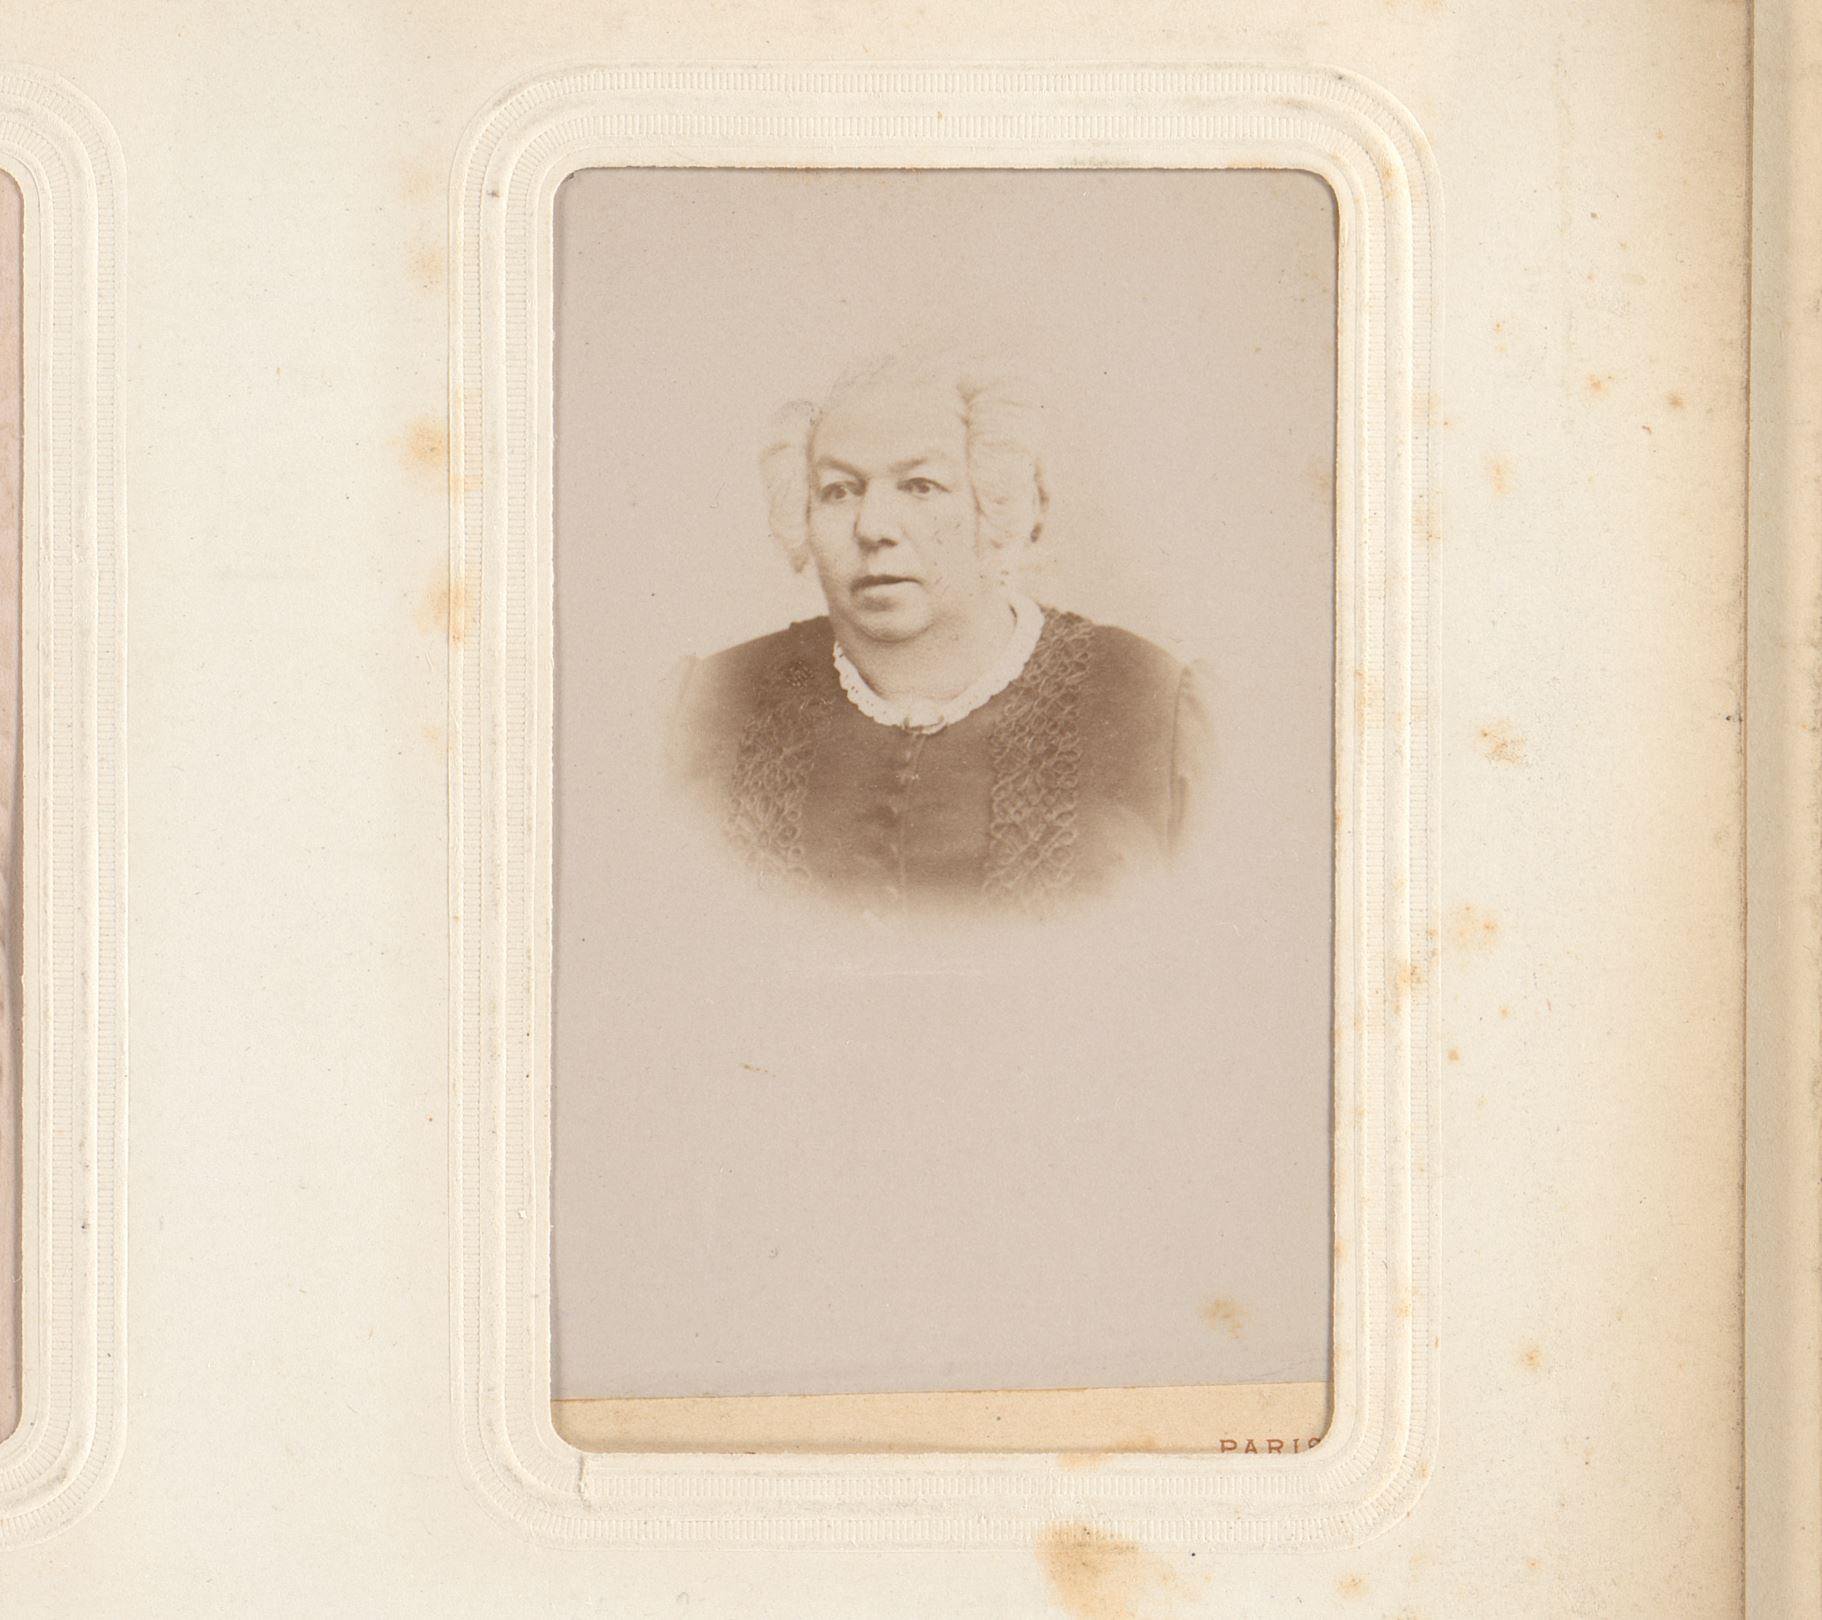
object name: album leaf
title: Portret van een vrouw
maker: michel berthaud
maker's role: publisher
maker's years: 1845-1912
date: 1891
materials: cardboard, paper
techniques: albumen print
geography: paris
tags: adult man, historical persons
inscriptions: inscription: ‘MEDAILLE D'OR/ 1889/ BERTHAUD/ 9, Rue Cadet, 9/ PARIS/ Tous le clichés sont conservés/ NO.... 1891/ J.H. Nacivet Paris’, inscription: ‘PARIS’, number: ‘42648’